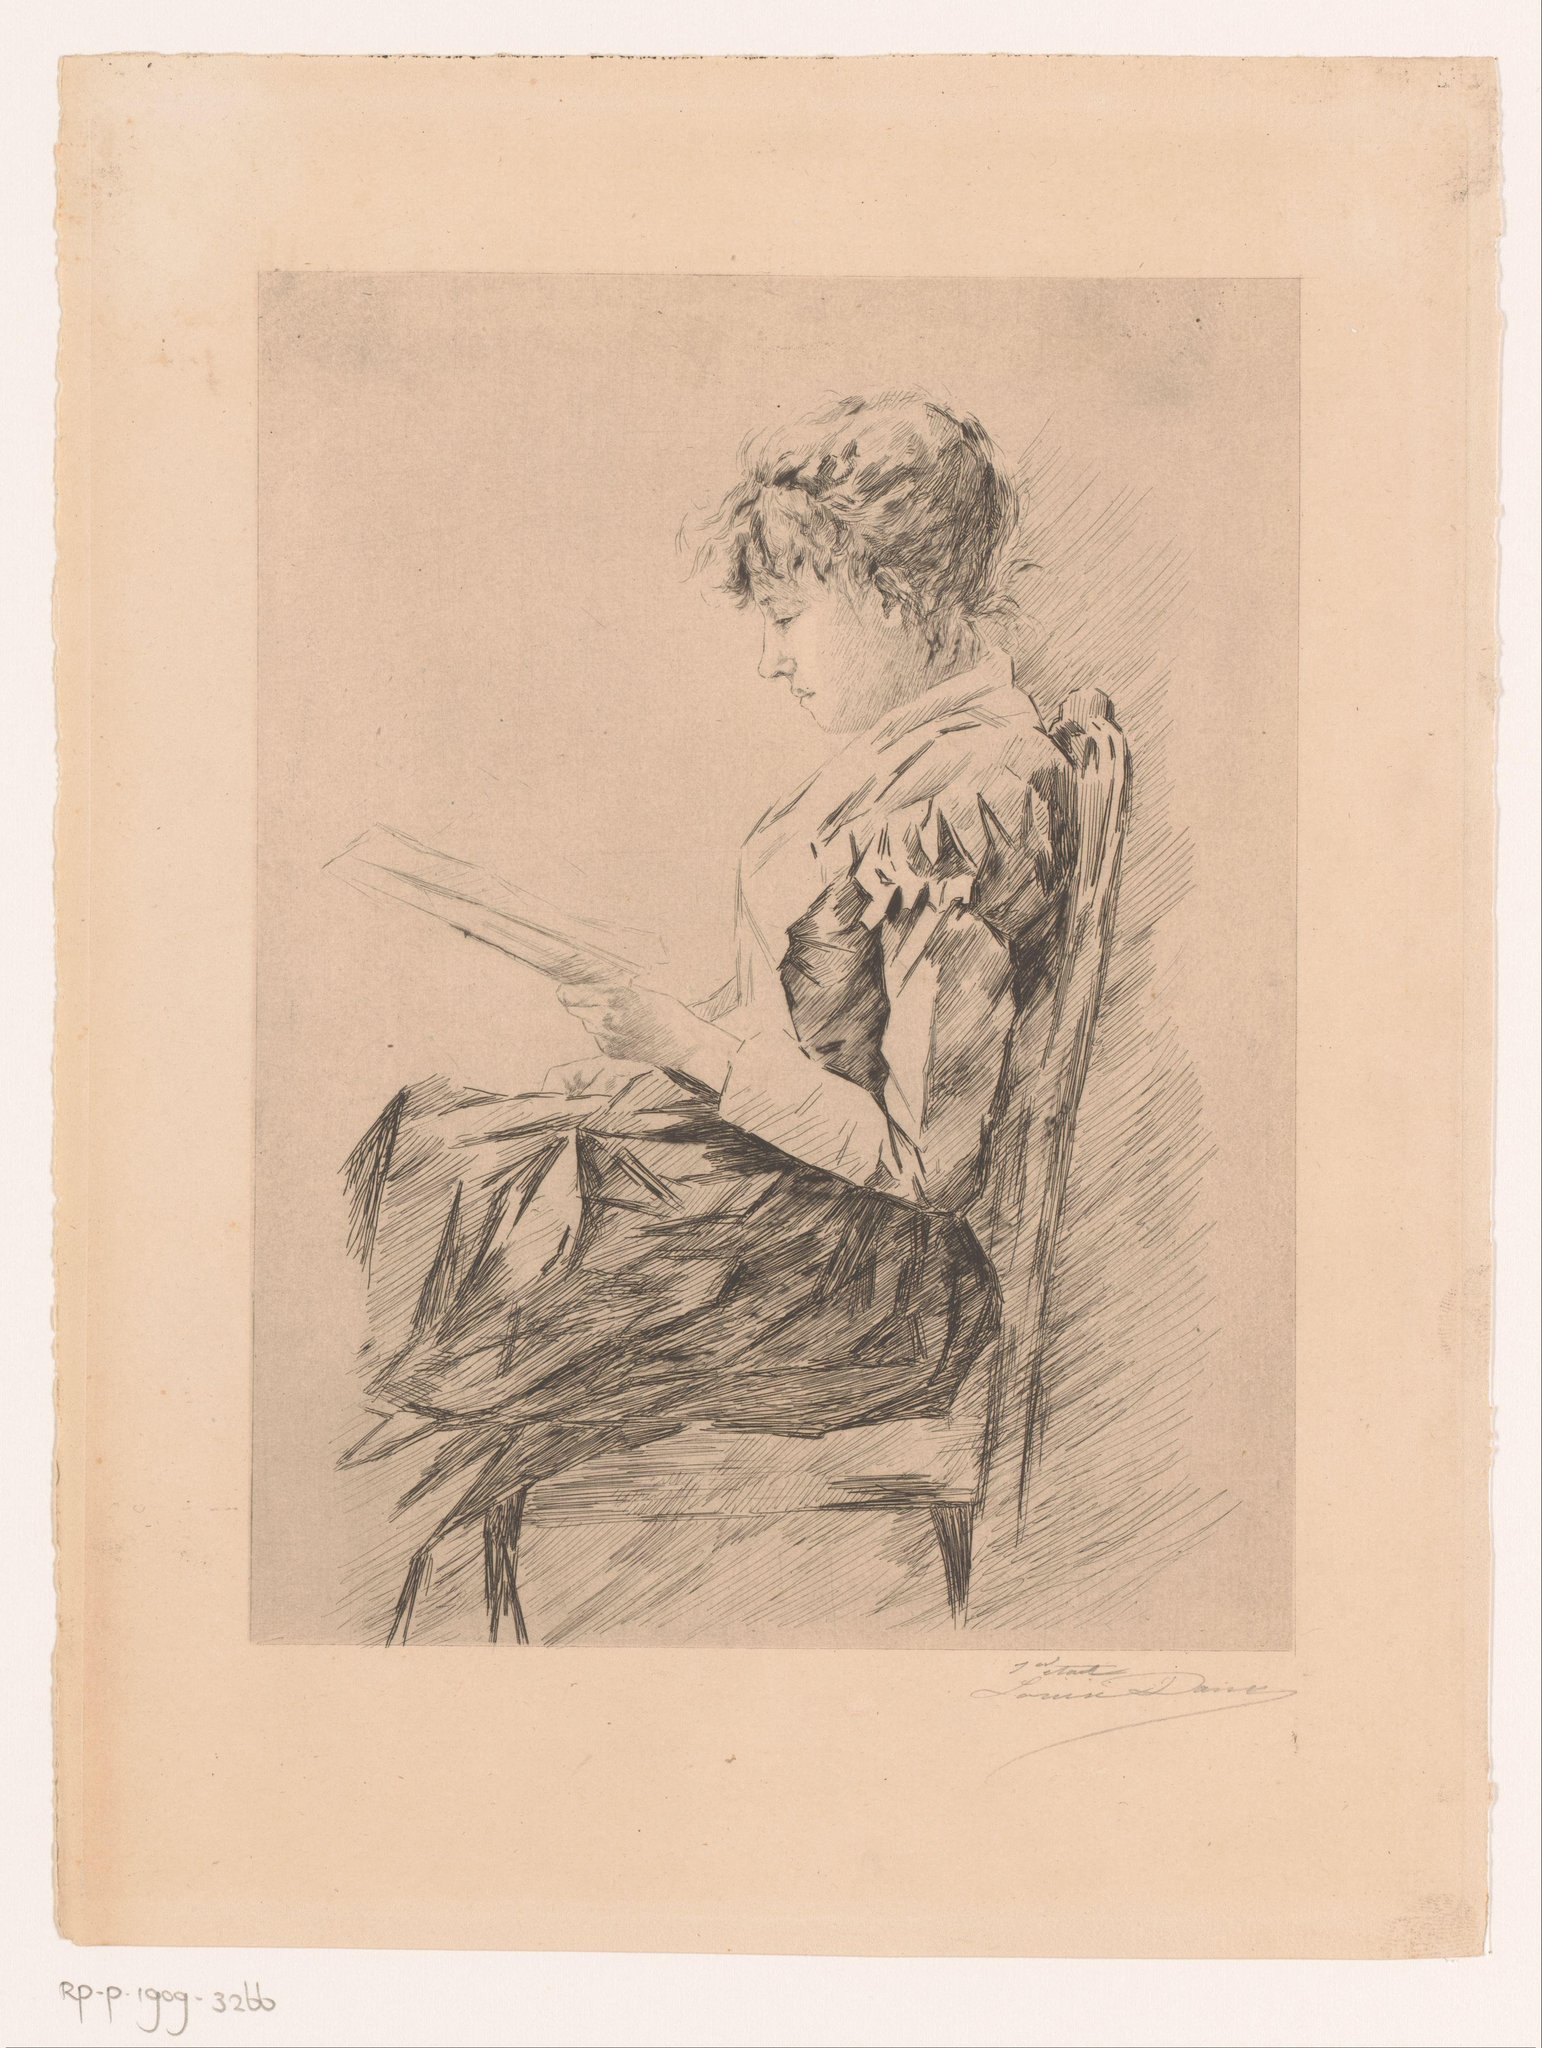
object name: print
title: Jonge vrouw leest een brief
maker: louise danse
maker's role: painter, print maker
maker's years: 1867-1948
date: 1877-1909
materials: paper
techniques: drypoint, etching, intaglio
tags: reading, letter, envelope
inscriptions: collector's mark: Lugt 2228, annotation: ‘1er état’